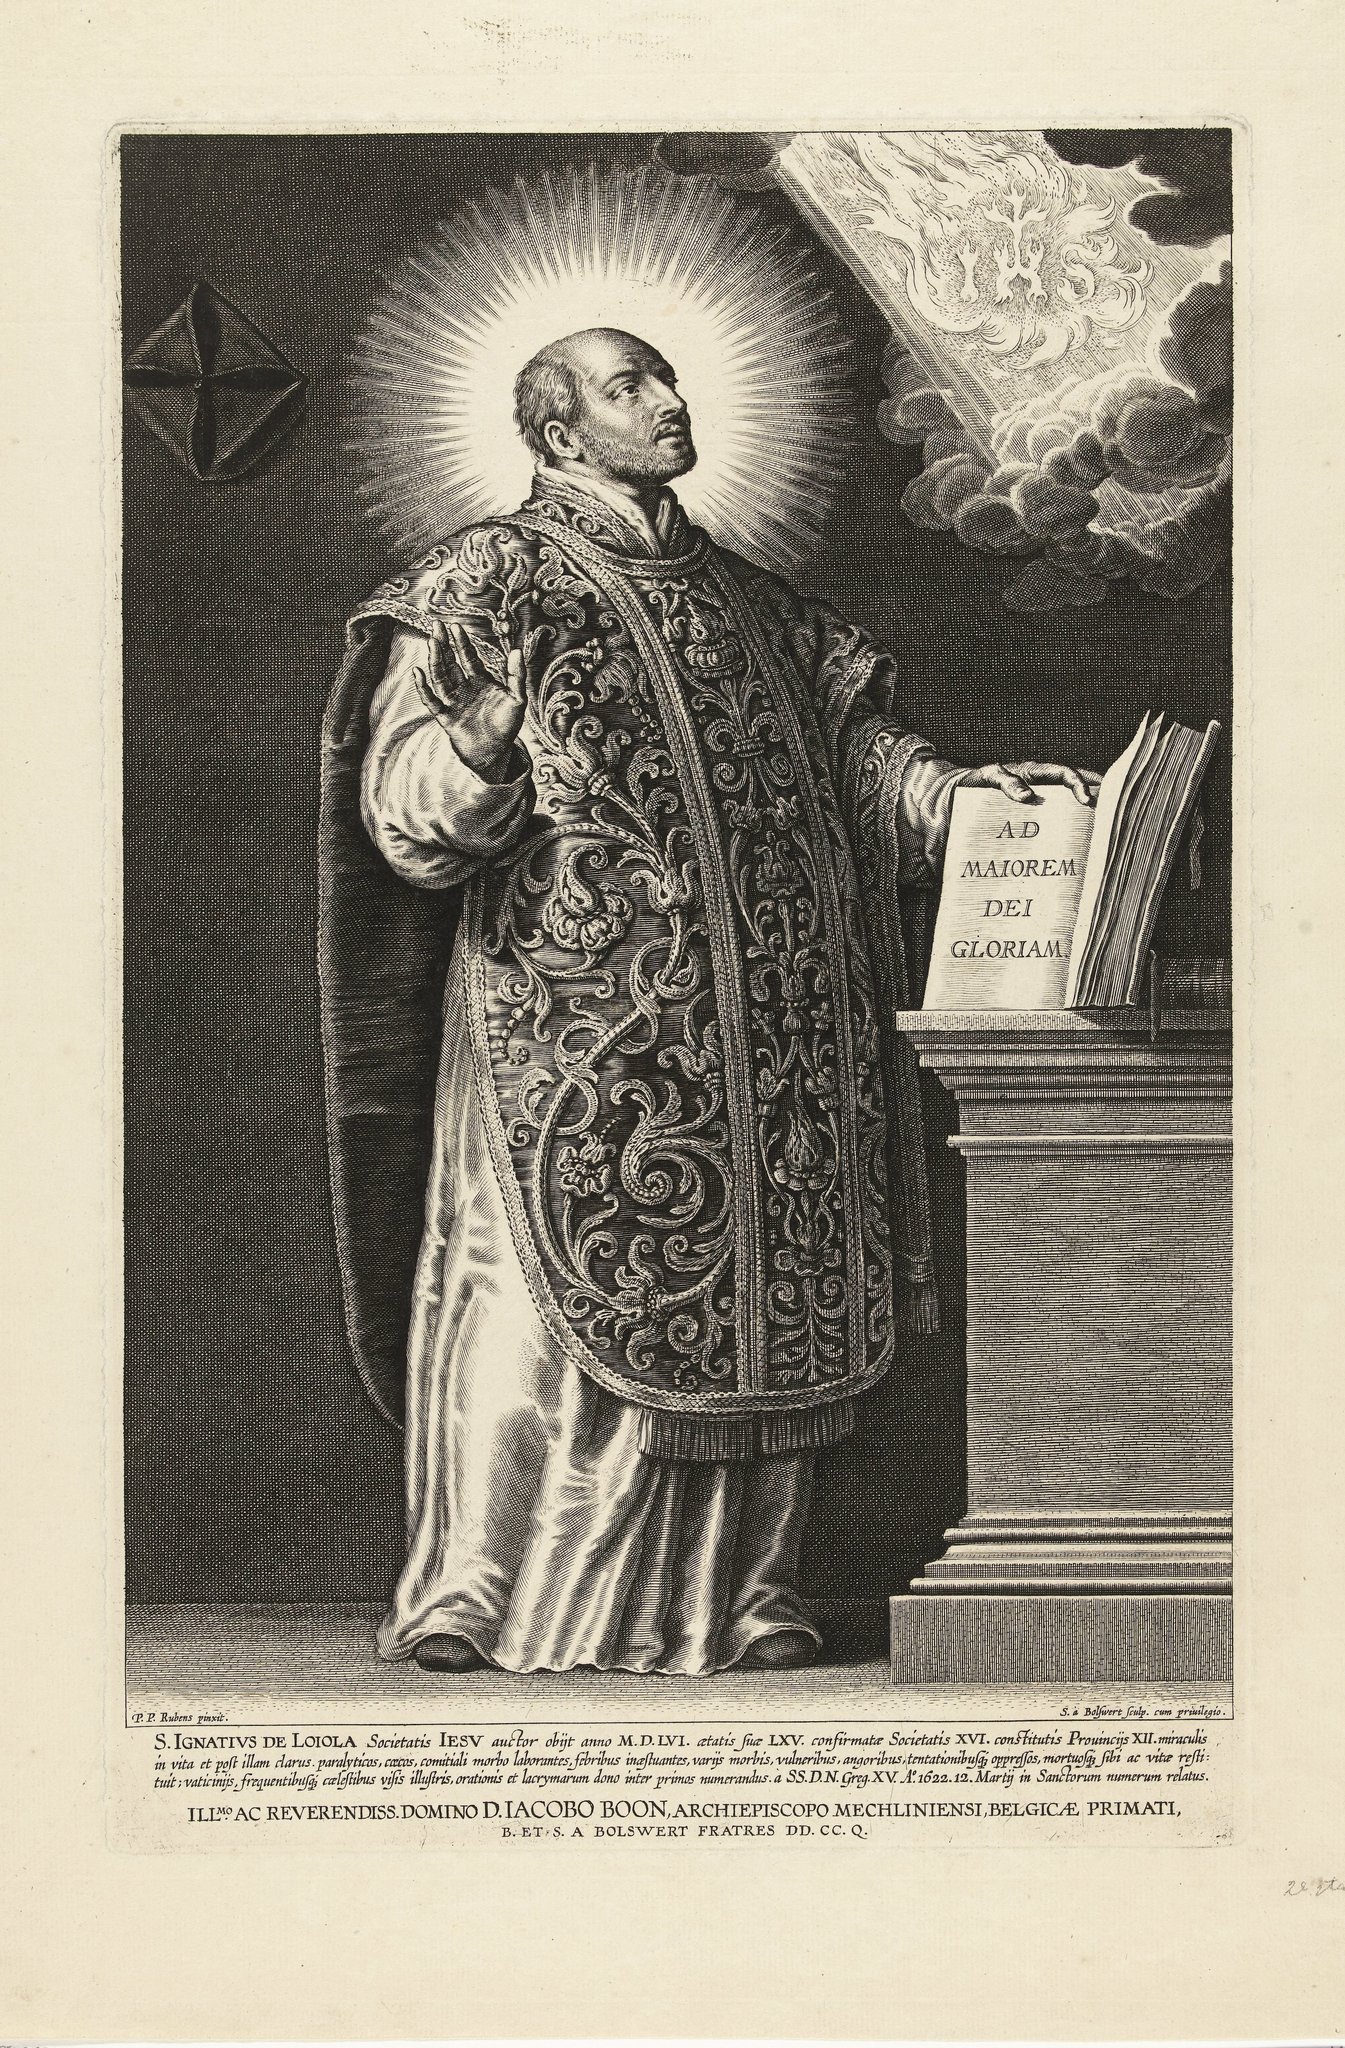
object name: print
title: Heilige Ignatius van Loyola met monogram IHS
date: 1622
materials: paper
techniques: engraving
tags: ihs ('iesus hominum salvator') ~ symbol of christ, the founder of the jesuit order, ignatius of loyola; possible attributes: book (with 'ad majorem dei gloriam'), demon, dragon under feet, flames, flaming heart, globe, ihs monogram, skull (with crown), tears in eyes, torch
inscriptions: collector's mark: Lugt 240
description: Ignatius van Loyola als een man van middelbare leeftijd, kalend met een korte, donkere baard. Zijn hoofd is omgeven door een aureool, een paar tranen rollen uit het rechteroog. Zijn kazuifel is rijk geborduurd. De rechterhand is opgeheven, de linkerhand rust op zijn attribuut: een opengeslagen boek met het opschrift Ad majorem Dei Gloriam (Tot meerdere eer van God), de aanvangswoorden van de regel der jezuïeten. Rechtsboven, boven een aantal wolken, verschijnen in een stralenbundel de letters IHS, het monogram van de orde. Onder de voorstelling staat een tekst met de verdiensten van de heiligen.